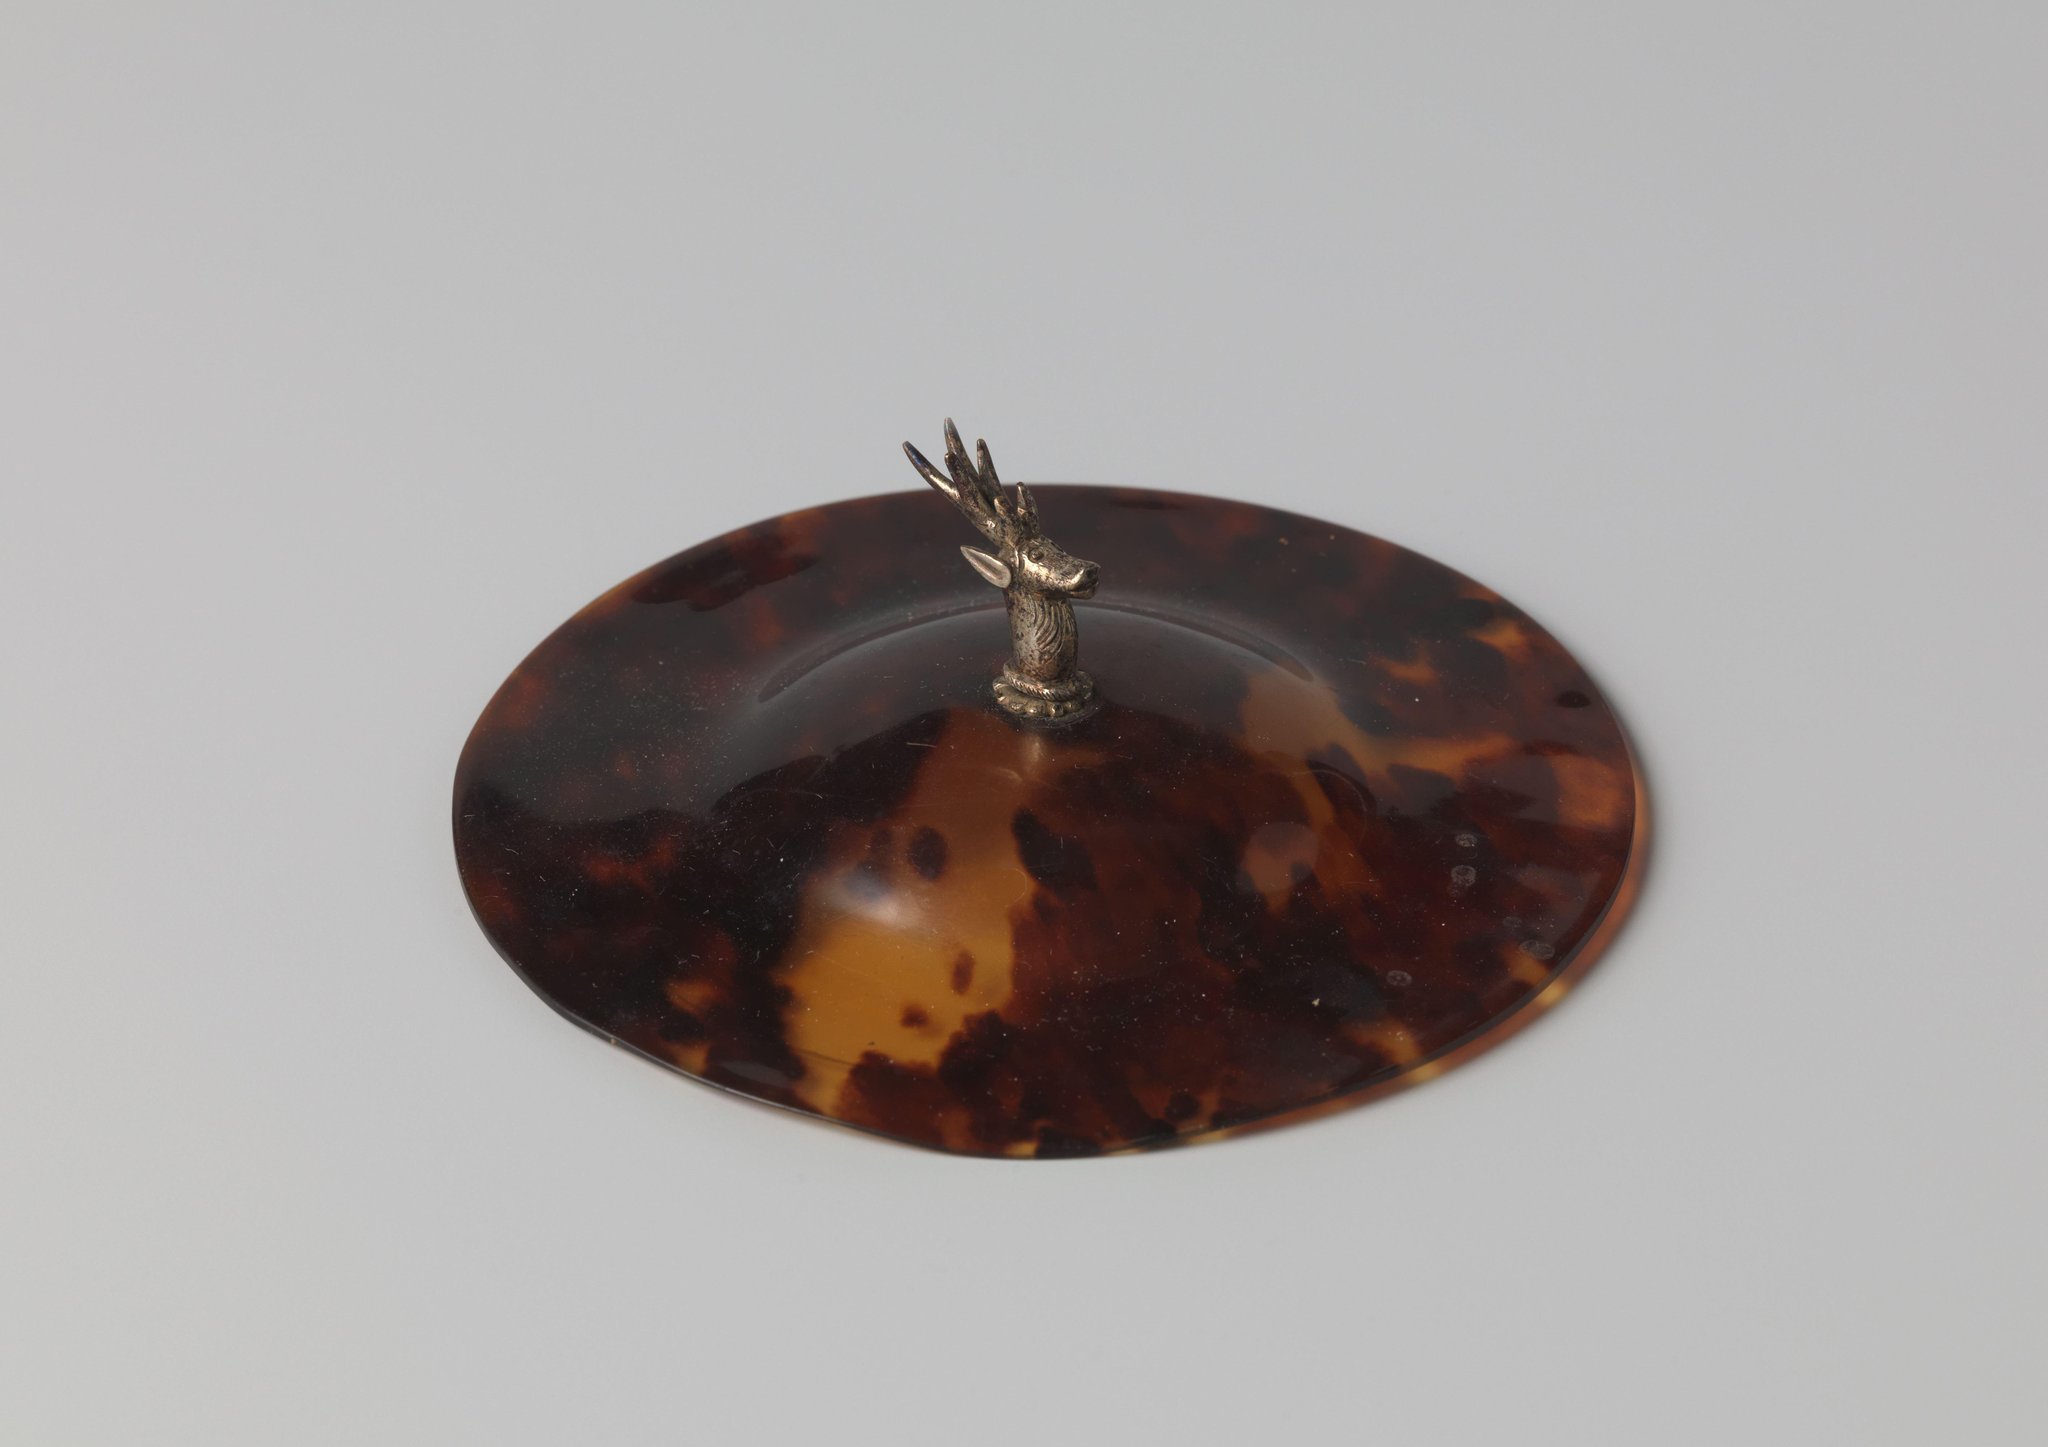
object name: schildpaddeksel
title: Deksel van schildpad met hertekop van zilver (serie van 28 stuks A t/m BB)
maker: Anonymous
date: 1700-1799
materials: silver, shell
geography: indonesia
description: Schildpad-deksel (28 stuks: A t/m BB) met hertekop van zilver als knop.